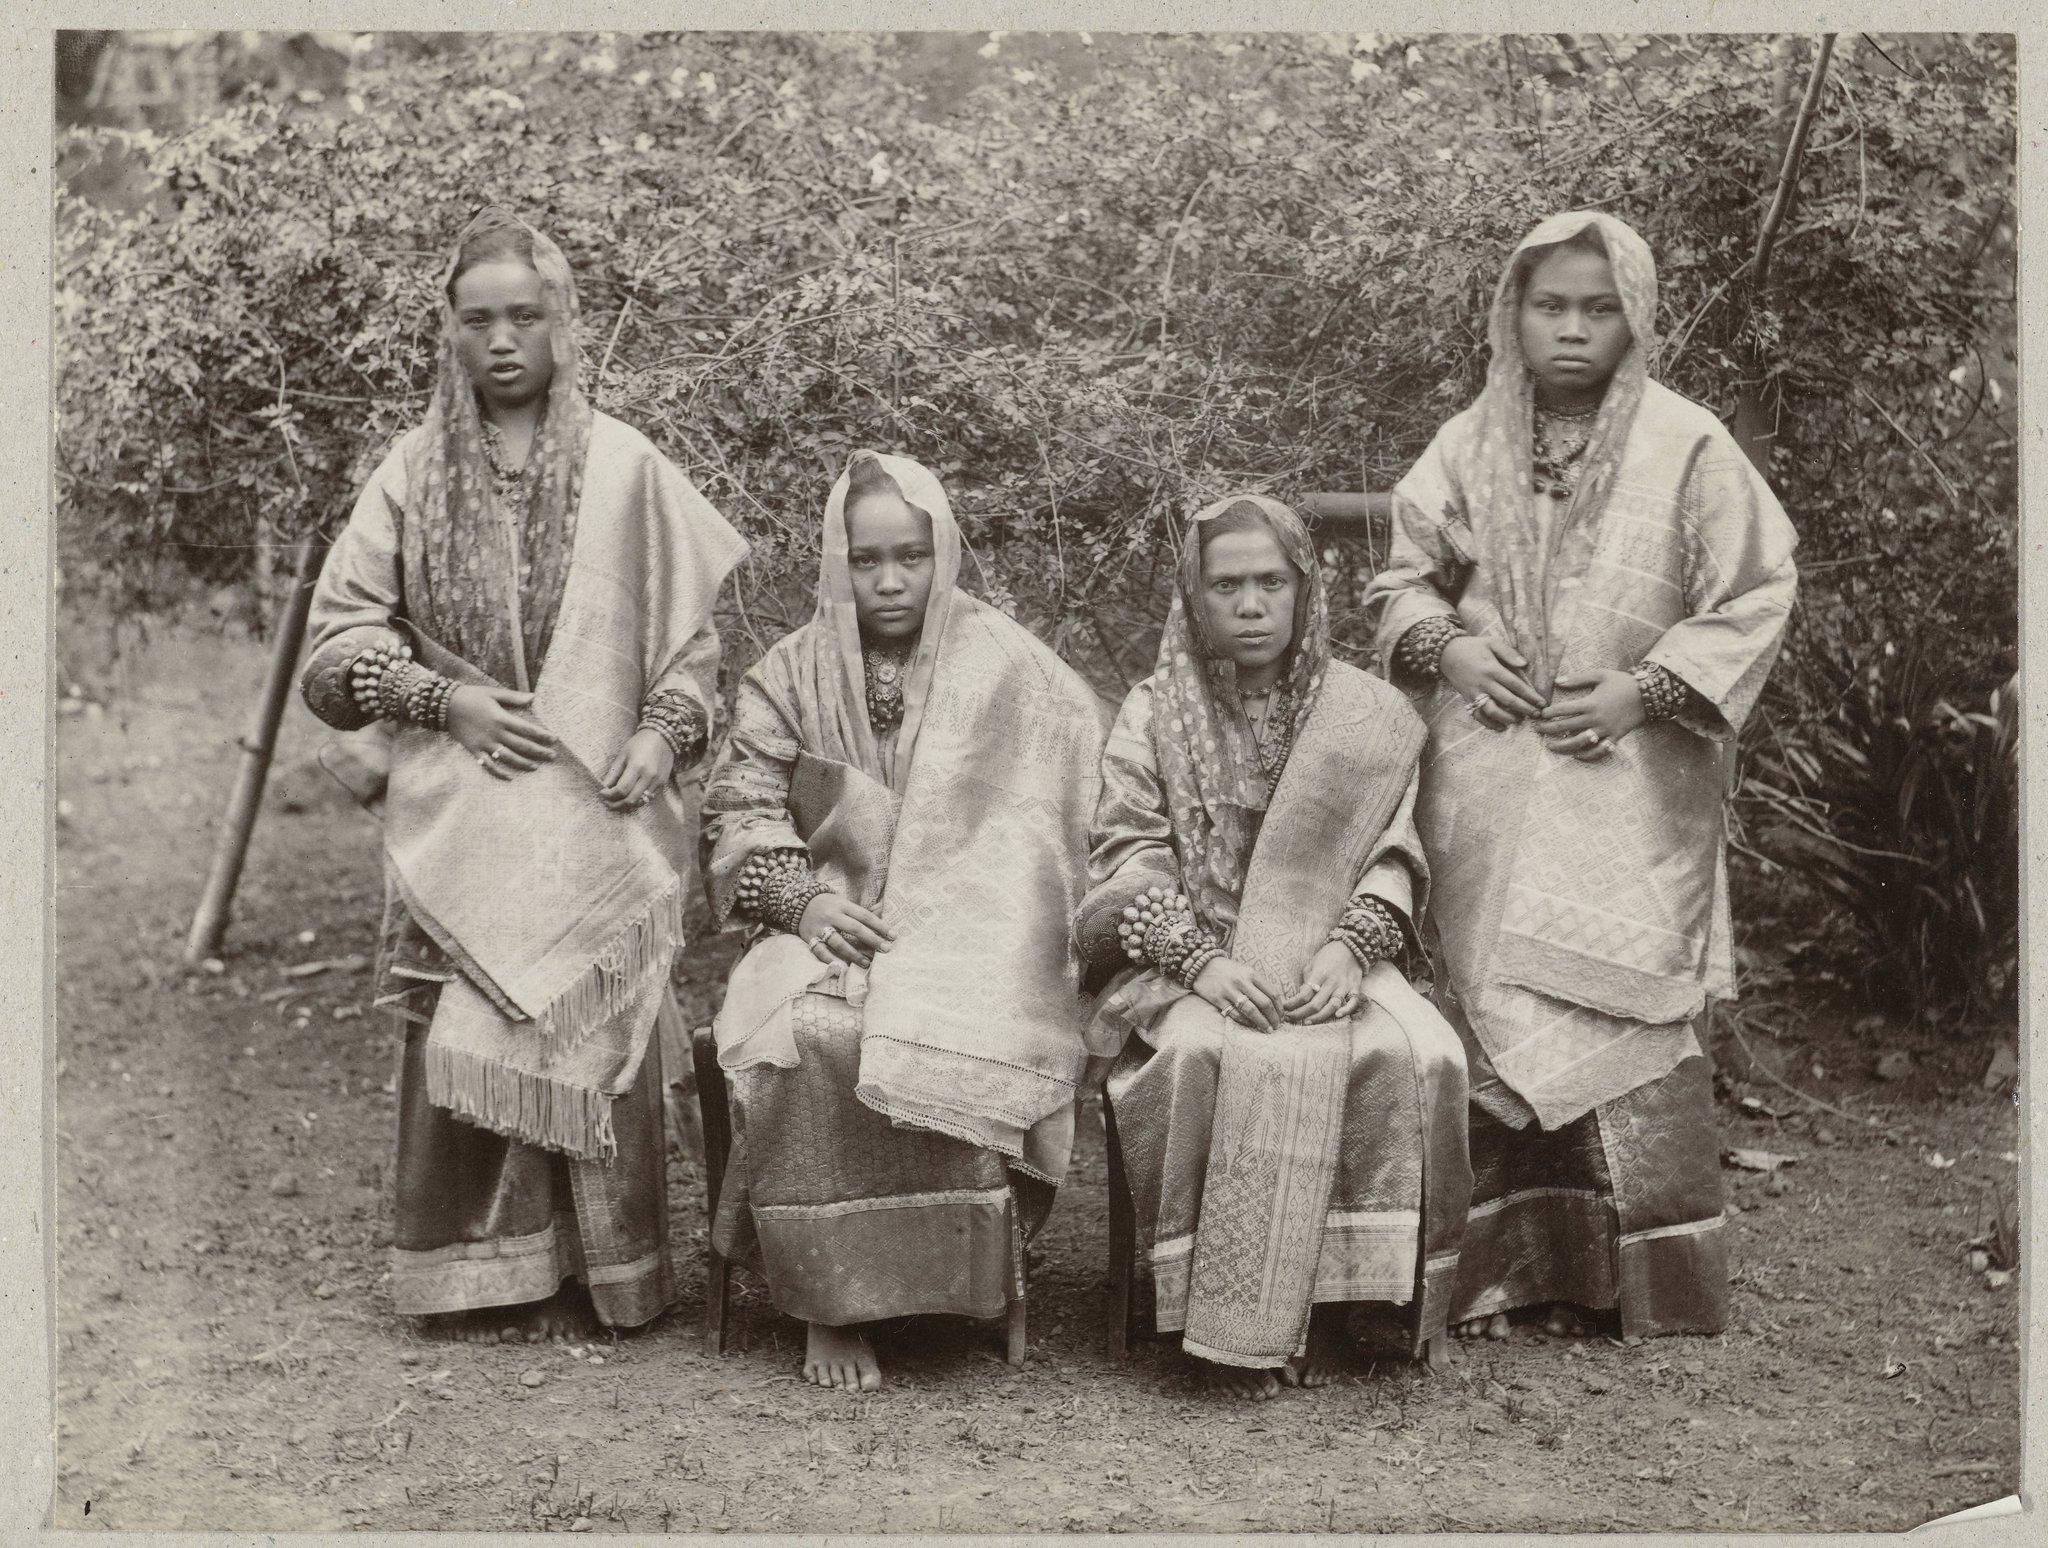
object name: photograph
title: Portret van vier onbekende vrouwen in Indonesië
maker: christiaan benjamin nieuwenhuis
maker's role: publisher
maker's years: 1863-1922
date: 1891-1912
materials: paper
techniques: albumen print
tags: anonymous historical persons portrayed in a group, in a group-portrait - bb - woman, folk costume, regional costume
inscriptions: inscription: ‘Bovenl. vrouwen’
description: De vier vrouwen dragen traditionele kleding met batik sarong en veel sieraden.